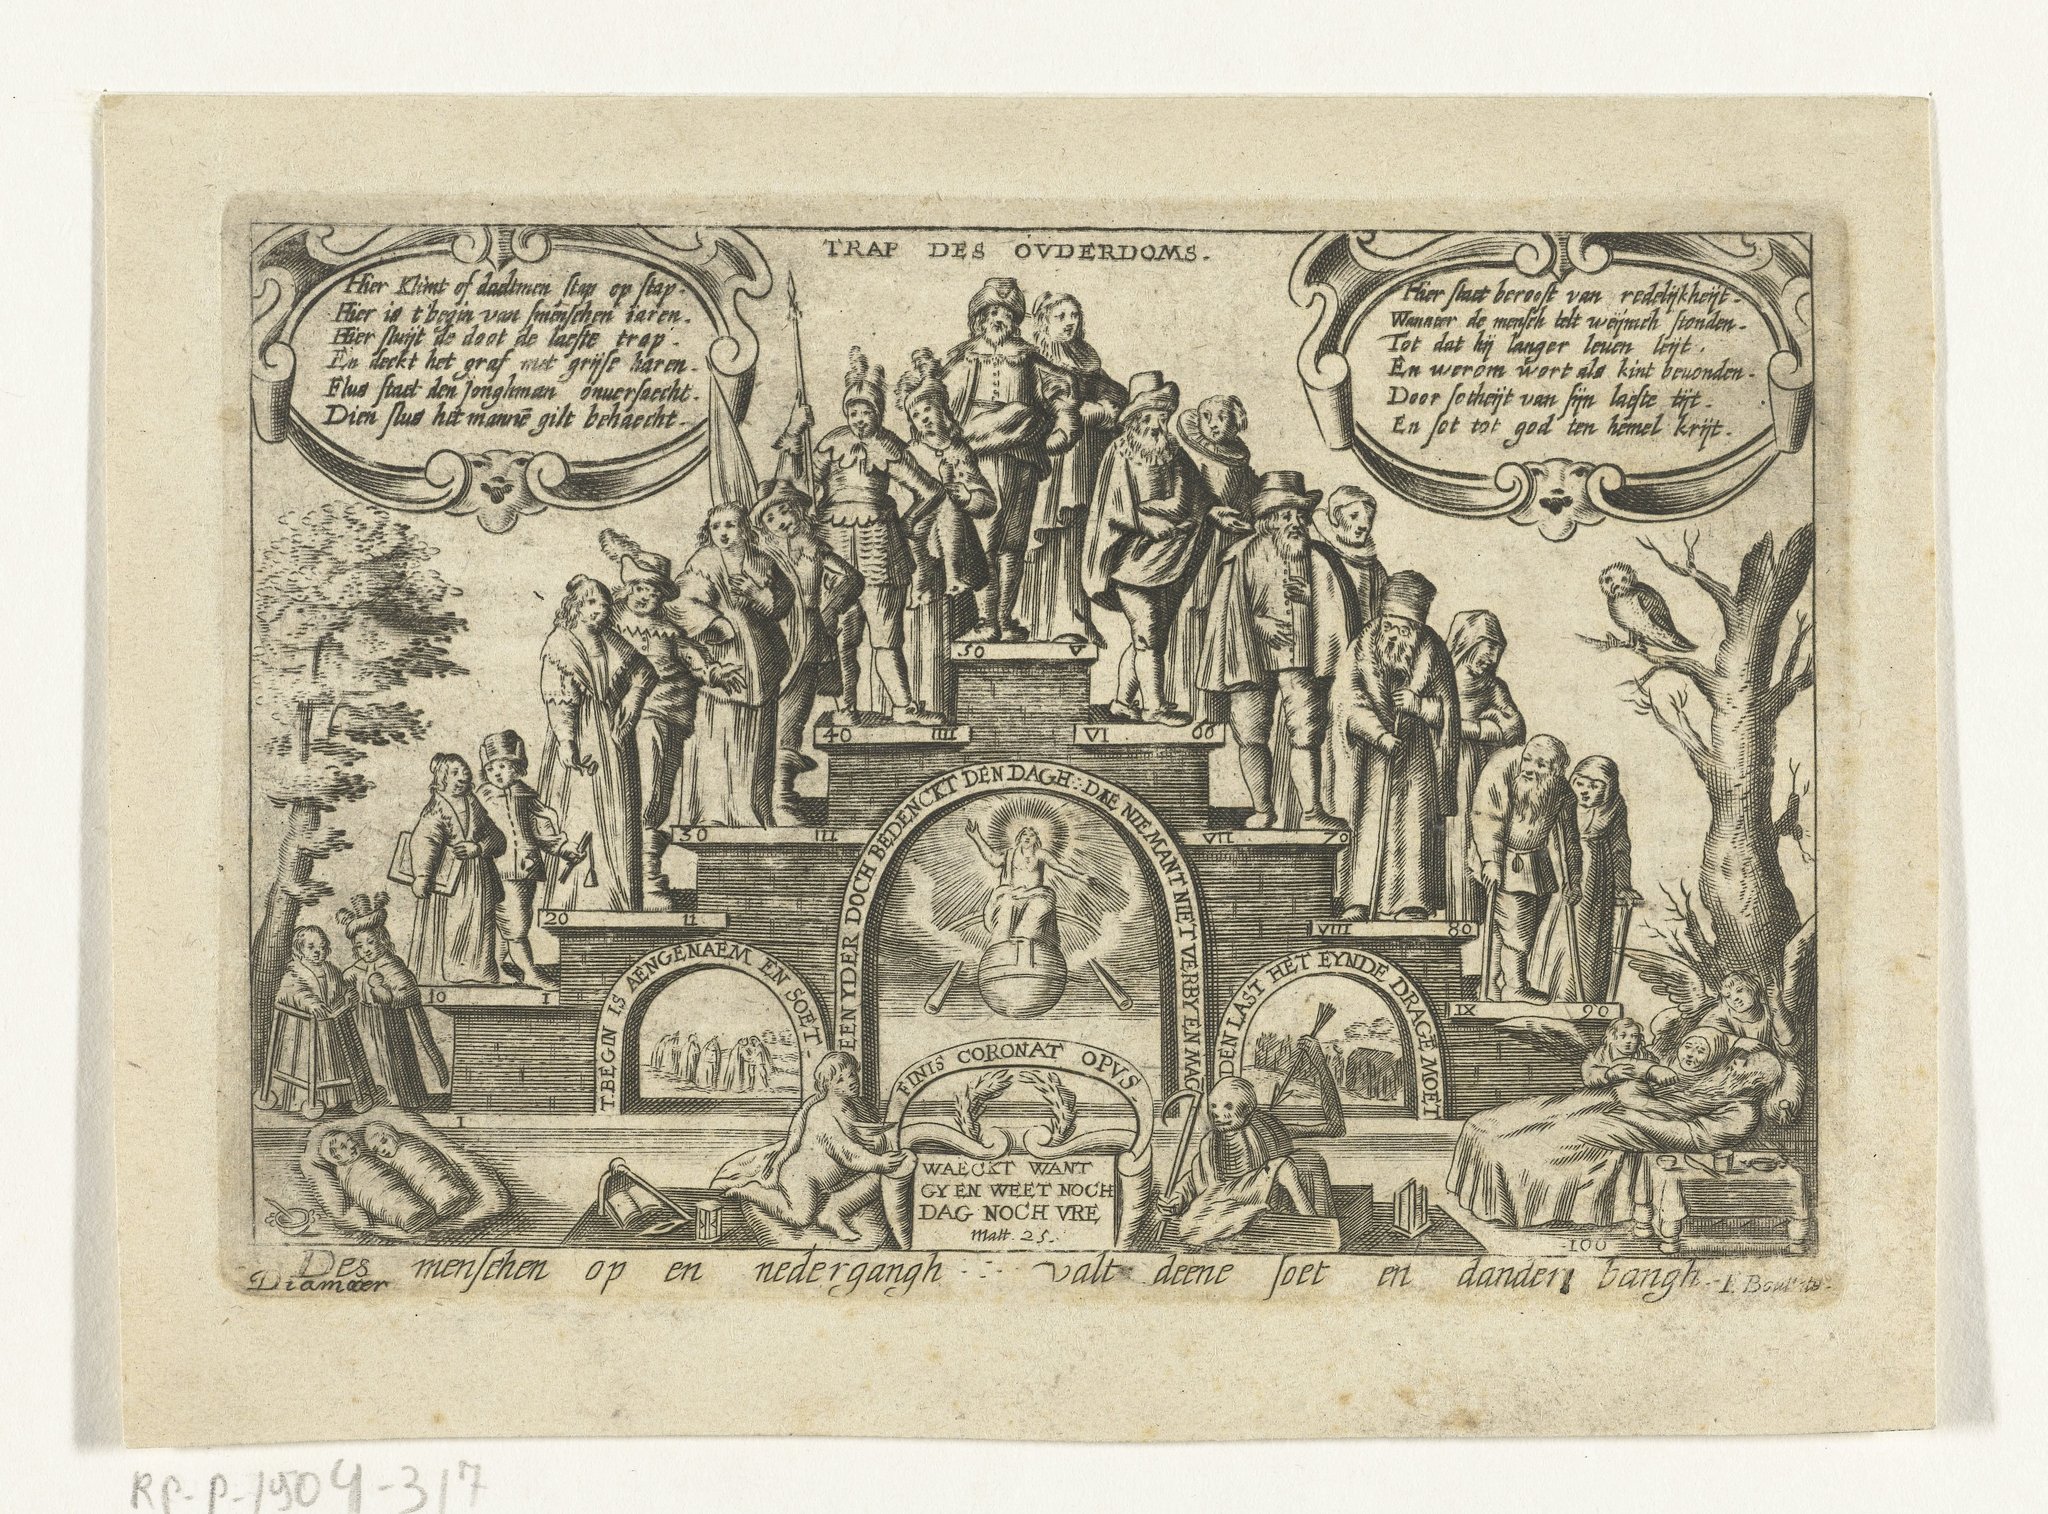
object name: print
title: Levenstrap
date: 1600-1661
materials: paper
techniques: engraving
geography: antwerp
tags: god the father as young or adult man (perhaps resembling christ), the ages of man represented by a staircase (11)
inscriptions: collector's mark: Lugt 2228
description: De verschillende fasen van het menselijk leven weergegeven door middel van figuren die klimmend en na hun vijftigste jaar afdalend de verschillende levensfasen symboliseren. De levenstrap begint bij de mens (zowel man als vrouw) als baby en eindigt met de dood. Cemtraal onderaan de trap Christus (of God) die op de wereld troont. Twee cartouches bovenaan links en rechts bevatten Nederlandse opschriften.